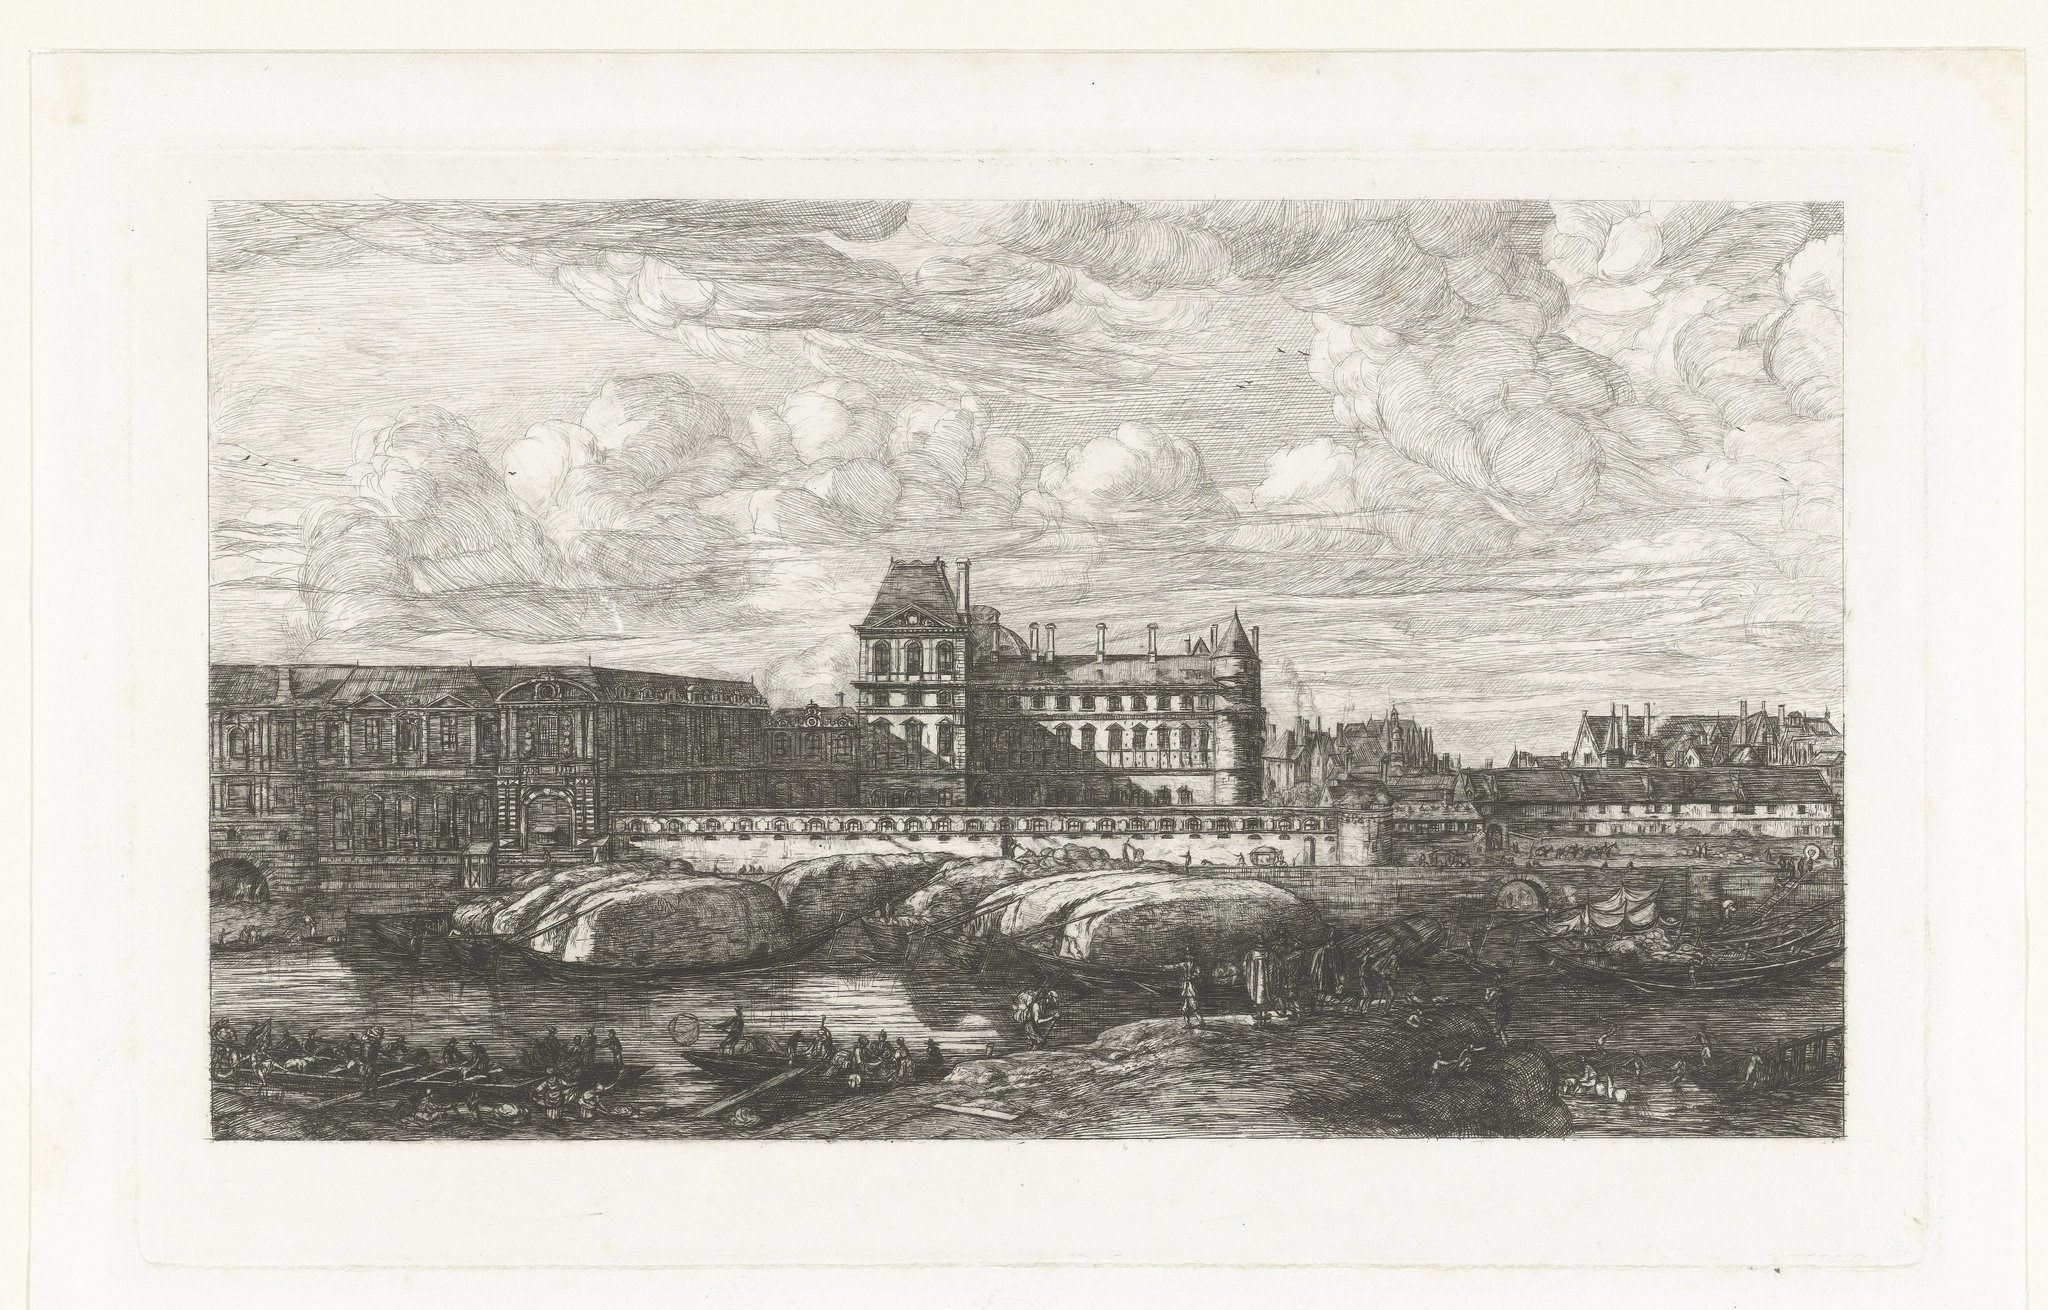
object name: print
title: Louvre op de oever van de Seine in Parijs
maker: charles meryon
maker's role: print maker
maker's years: 1821-1868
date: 1865-1866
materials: paper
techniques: drypoint, etching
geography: france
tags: river, palace, crafts and industries (+ transport of products ~ crafts, industries, agriculture)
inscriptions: collector's mark: stempel R. Vroom, check stamp: Lugt 1695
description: Gezicht op het Louvre in Parijs omstreeks 1650. Op de voorgrond de Seine met bedrijvigheid van werklieden, vissers en wasvrouwen. Vrachtboten zijn geladen met hooi. Aan de overkant op de oever van de rivier het oude Louvre. Meryon baseerde zich voor deze oude situatie op een schilderij van Reinier Nooms.